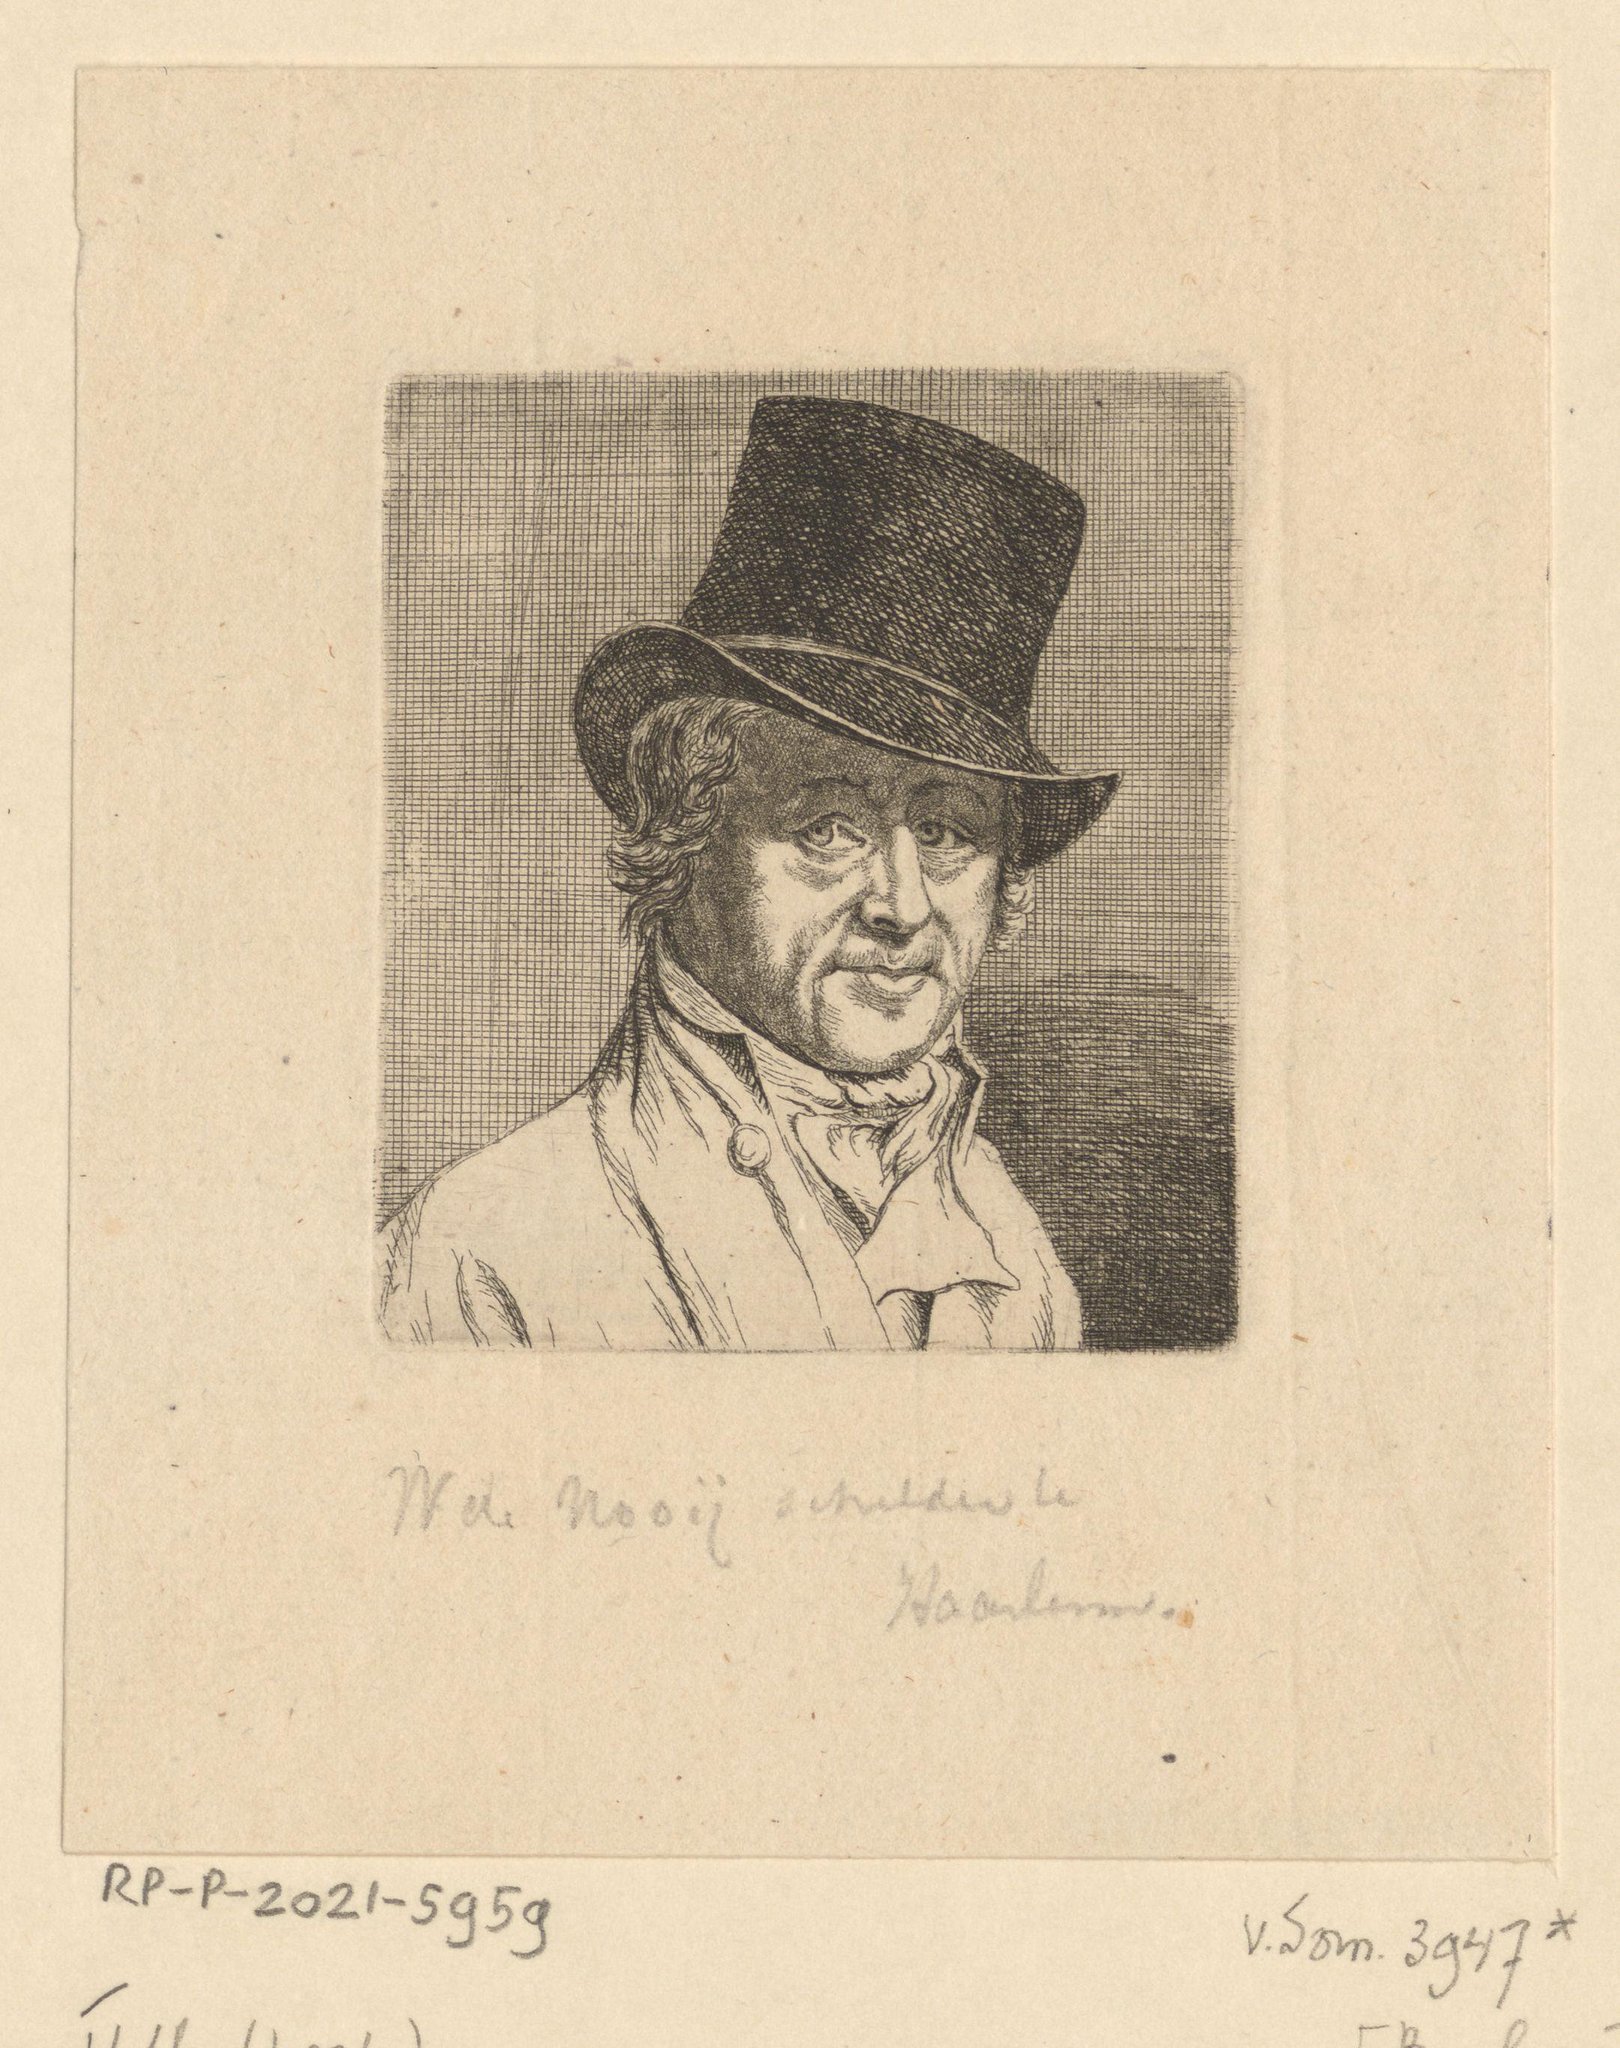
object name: print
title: Portret van Wouterus de Nooy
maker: ernst willem jan bagelaar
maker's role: draughtsman, print maker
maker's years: 1775-1837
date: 1785-1837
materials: paper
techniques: etching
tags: painter, wouterus de nooy, historical persons, portrait, self-portrait of painter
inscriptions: collector's mark: Lugt 2228, collector's mark: Lugt 2760